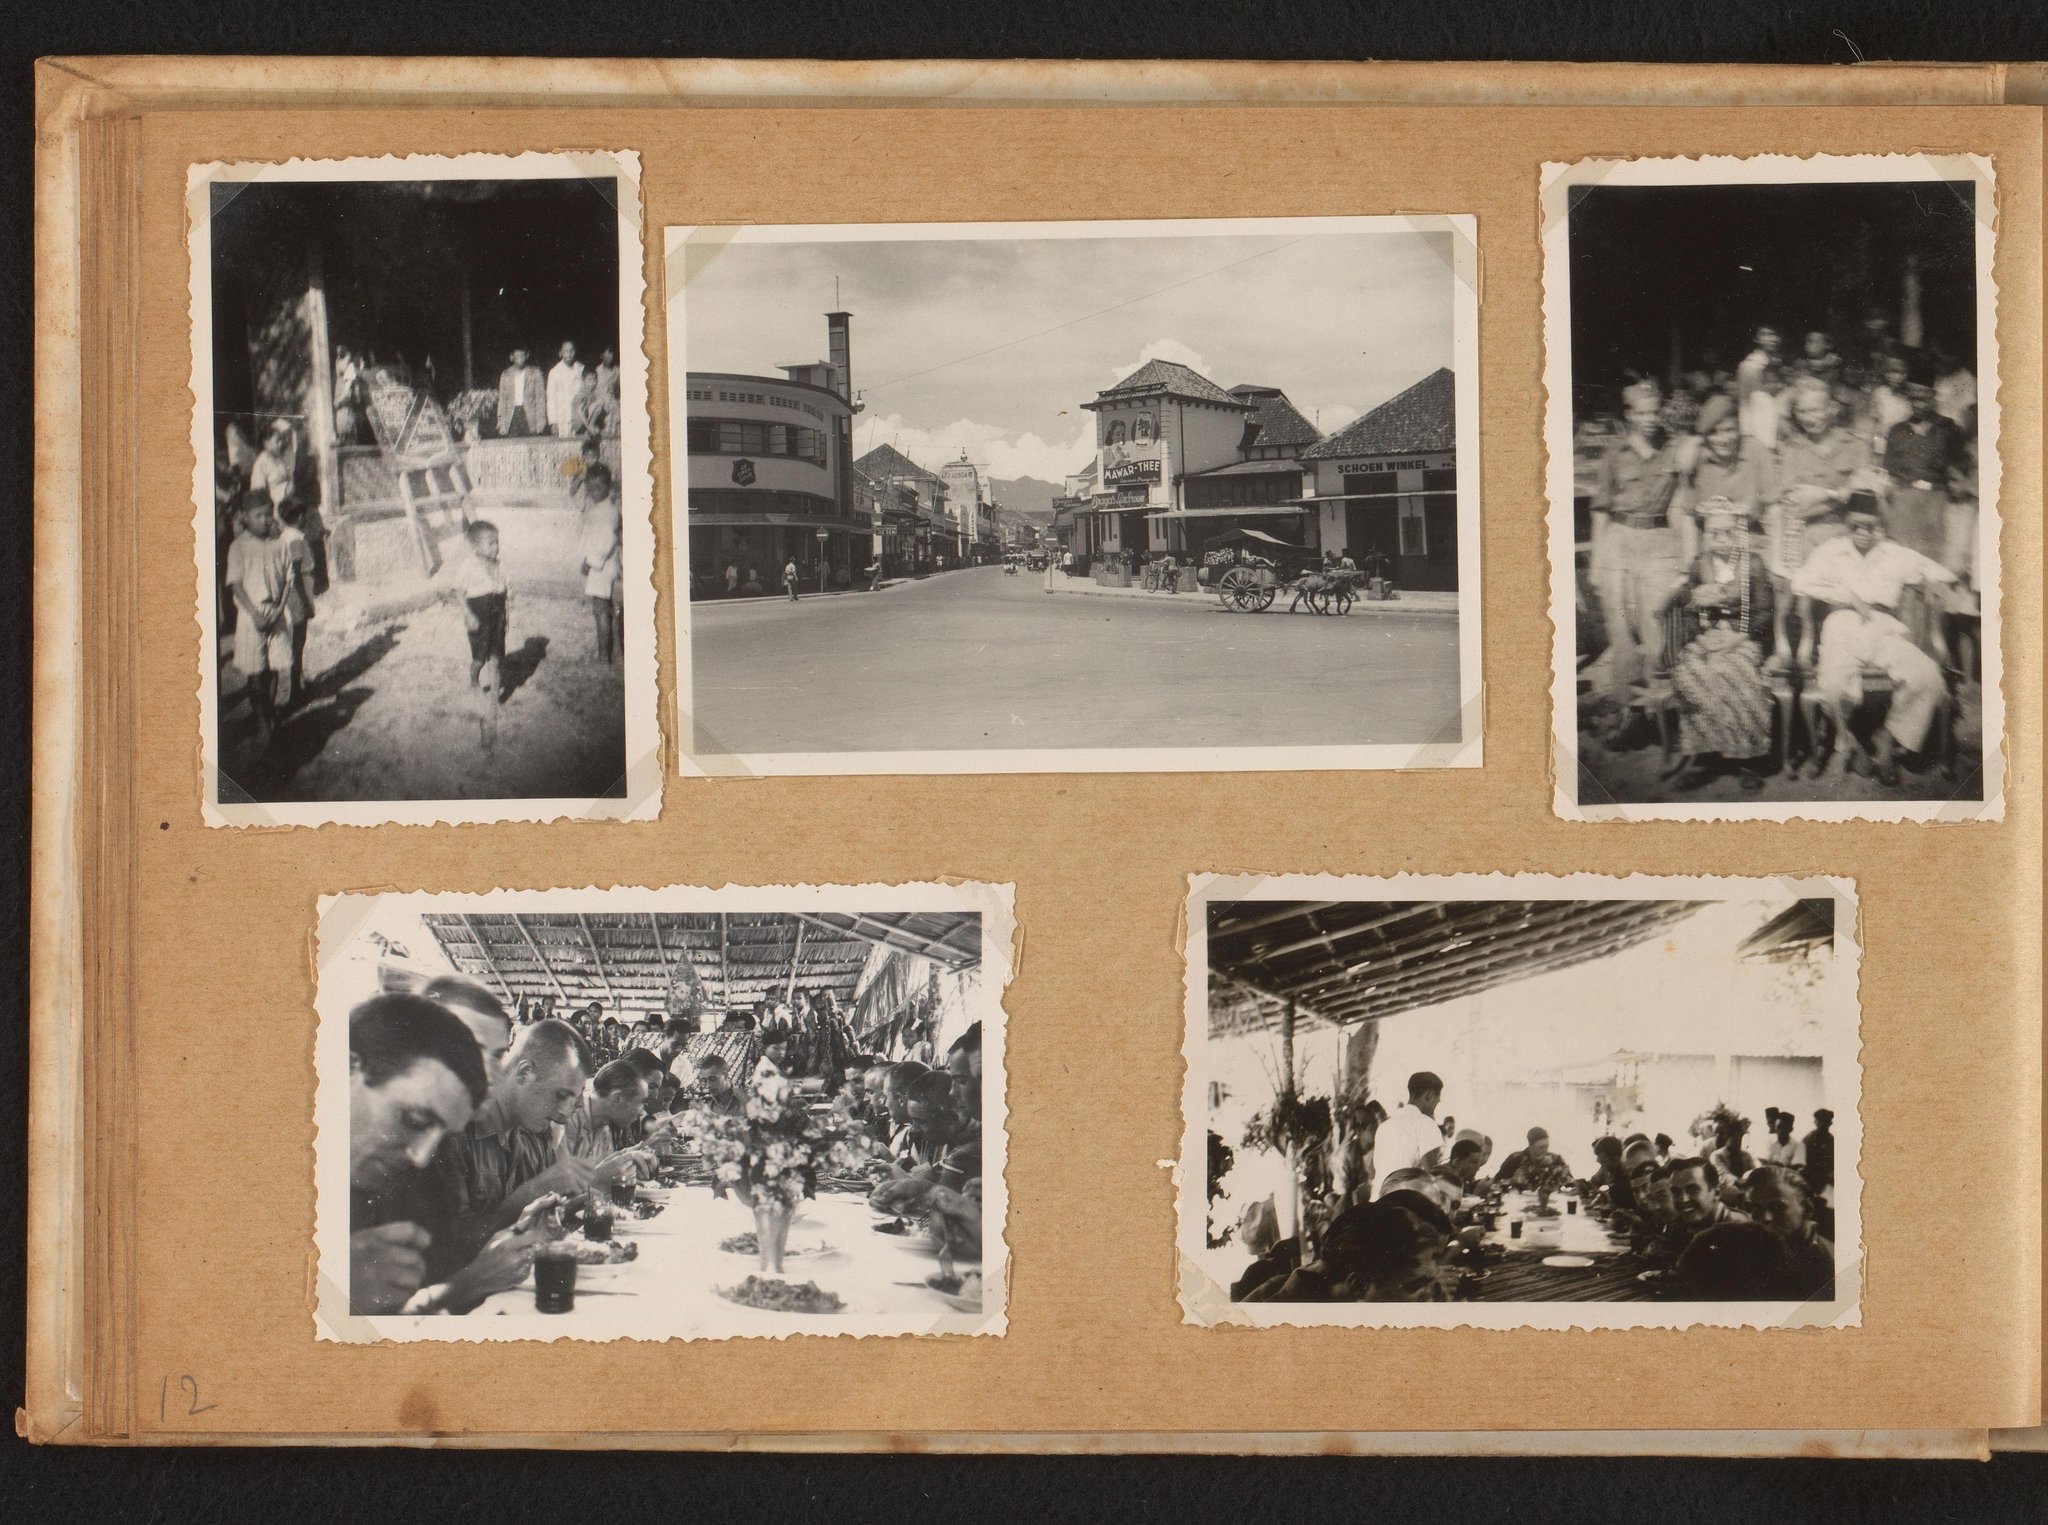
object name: photograph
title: Maaltijd en muzikanten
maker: Anonymous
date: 1948-1949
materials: paper, photographic support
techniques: gelatin silver print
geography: dutch east indies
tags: the company, the unit, the troop ~ military service, canteen ~ the soldier off duty, street, dutch east indies, the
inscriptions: inscription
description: Albumblad met vijf foto's van Nederlandse militairen etend aan lange tafels, kinderen in een dorp en straatgezicht. Onderdeel van het fotoalbum 'Ter herinnering aan mijn diensttijd overzee' 1948-1949.